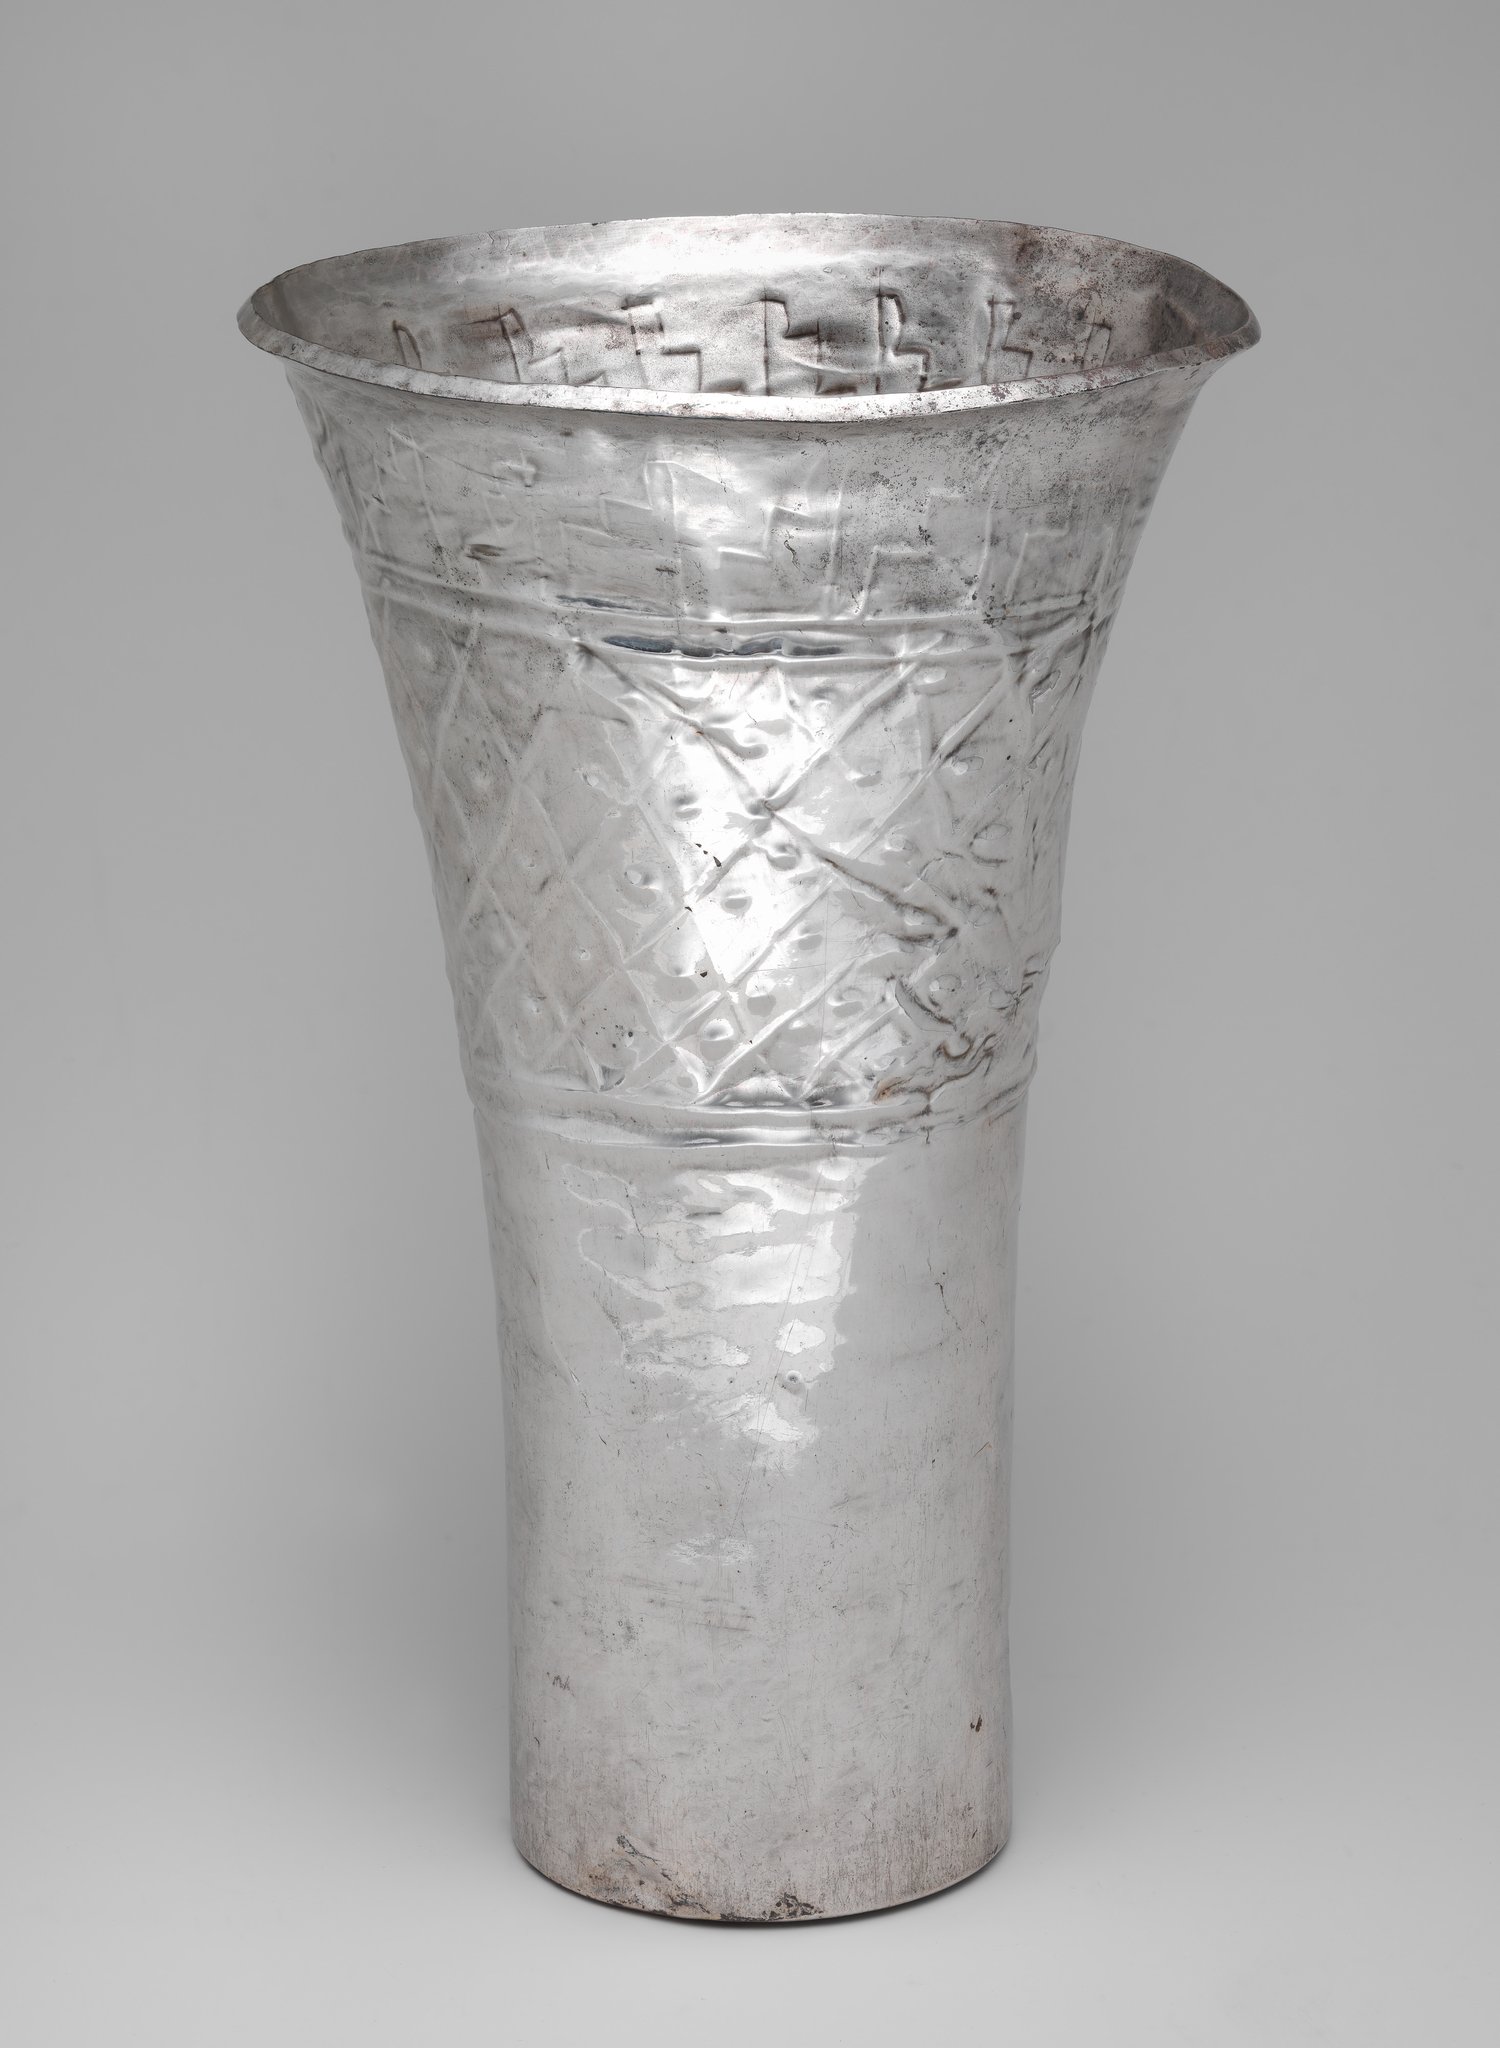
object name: beaker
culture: chimú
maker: chimú artist(s)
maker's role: artist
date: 1100-1470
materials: silver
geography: peru